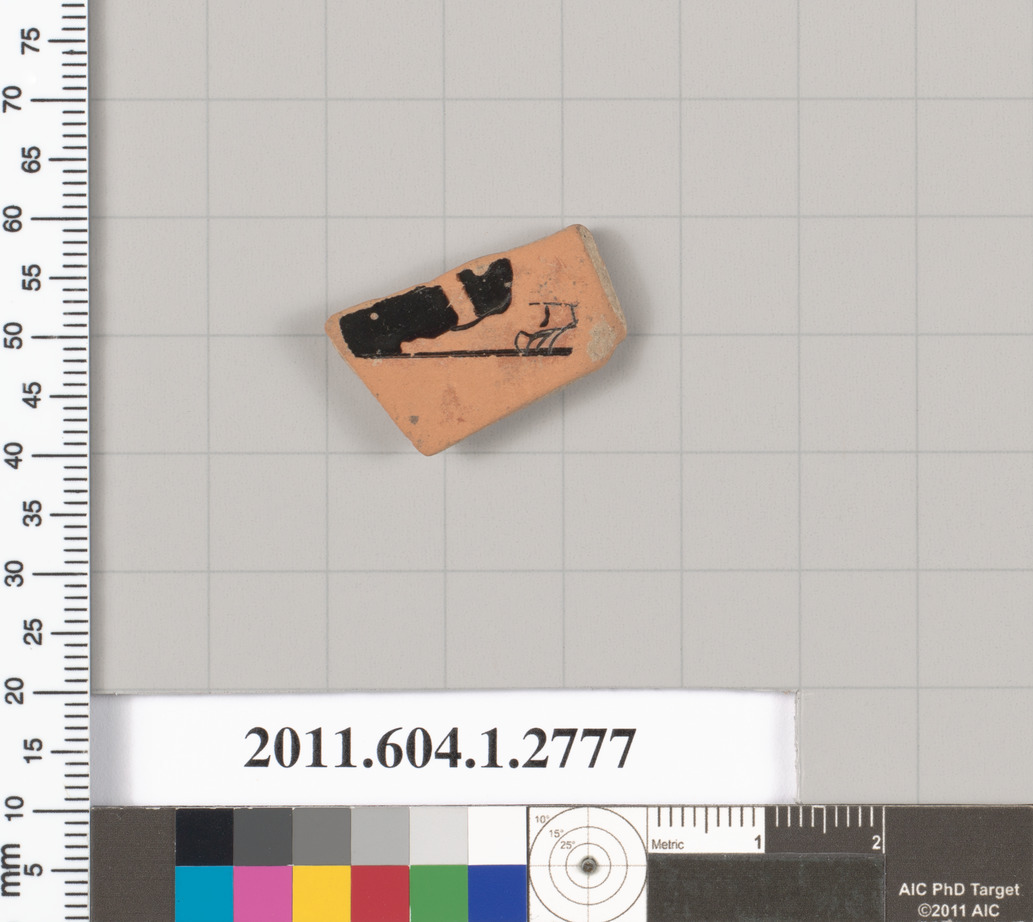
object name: kylix fragment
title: Terracotta fragment of a kylix (drinking cup)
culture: greek, attic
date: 500-451 BCE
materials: terracotta